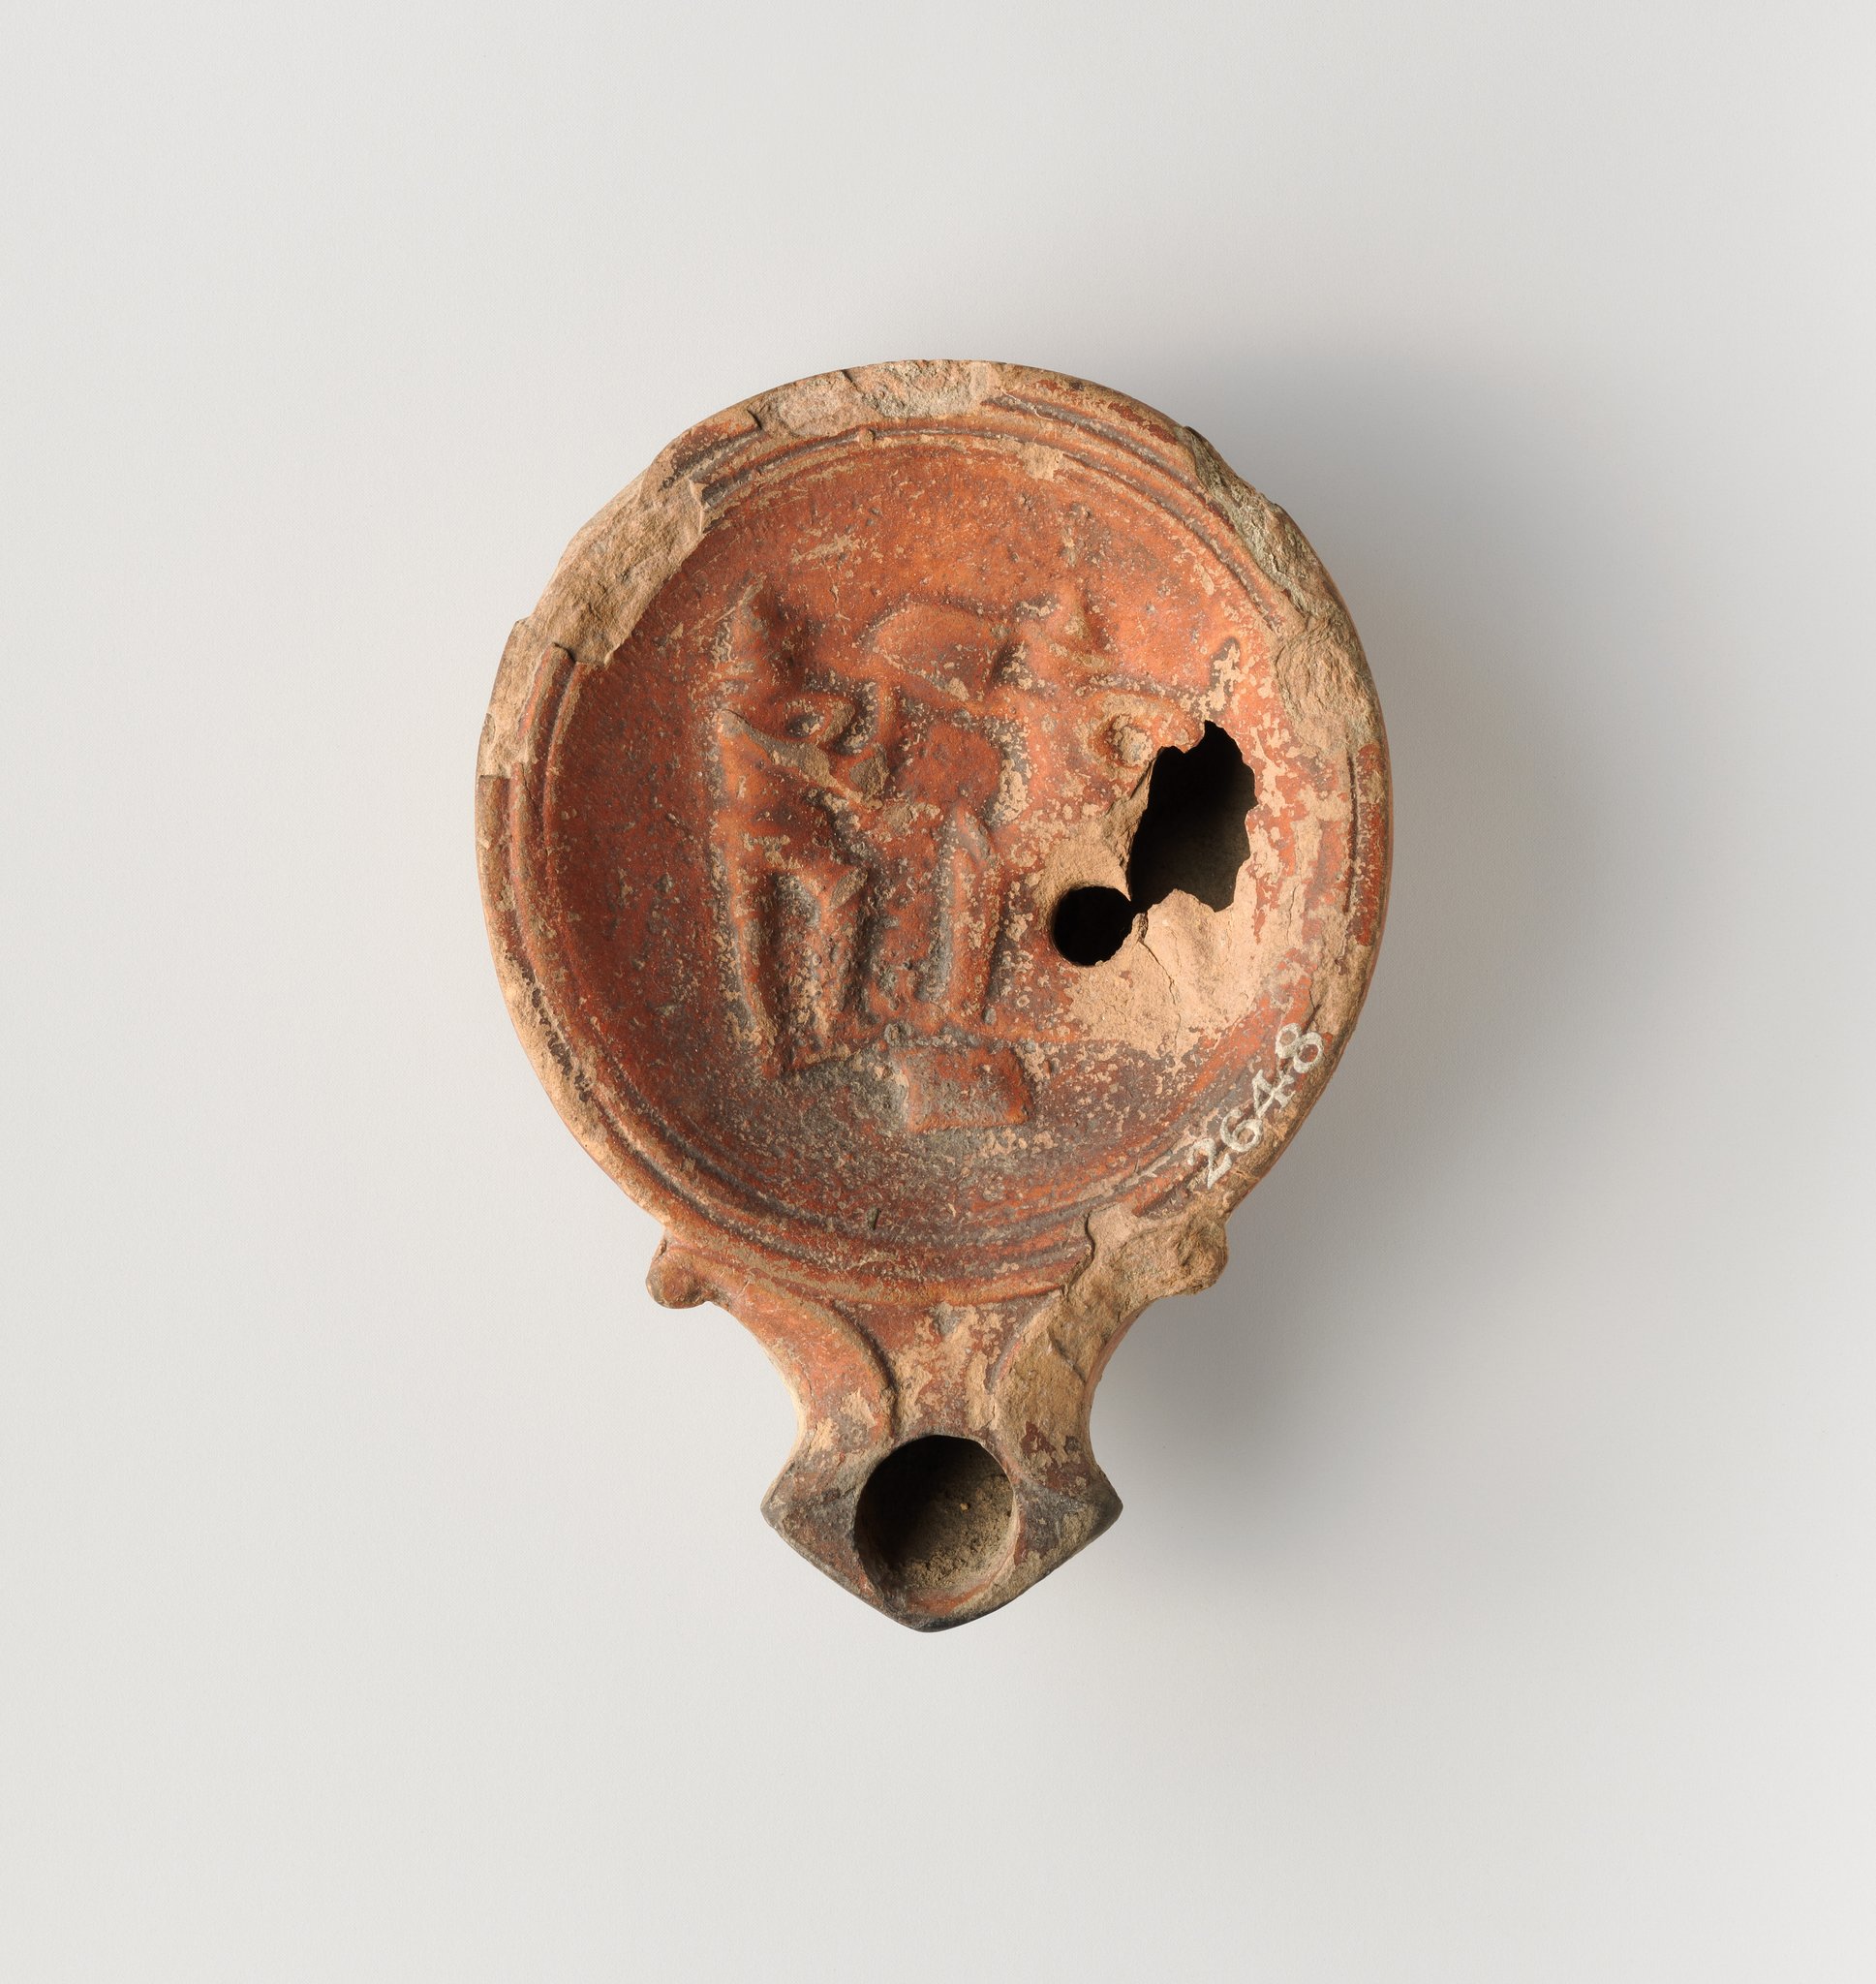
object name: lamp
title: Terracotta oil lamp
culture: roman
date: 100 BCE-100 CE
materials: terracotta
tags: gladiators